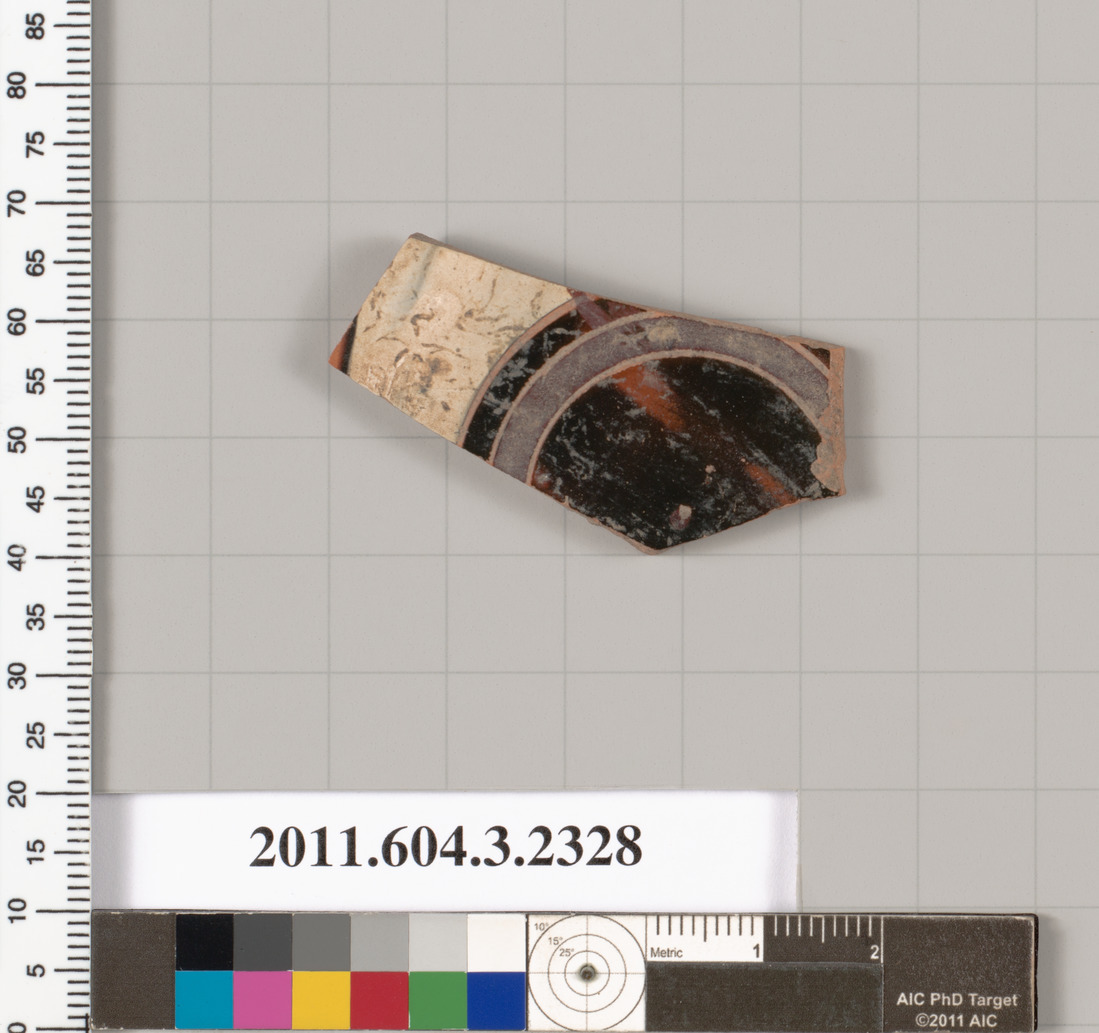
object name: kylix fragment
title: Terracotta fragment of a kylix: eye-cup (drinking cup)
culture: greek, attic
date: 540-520 BCE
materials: terracotta